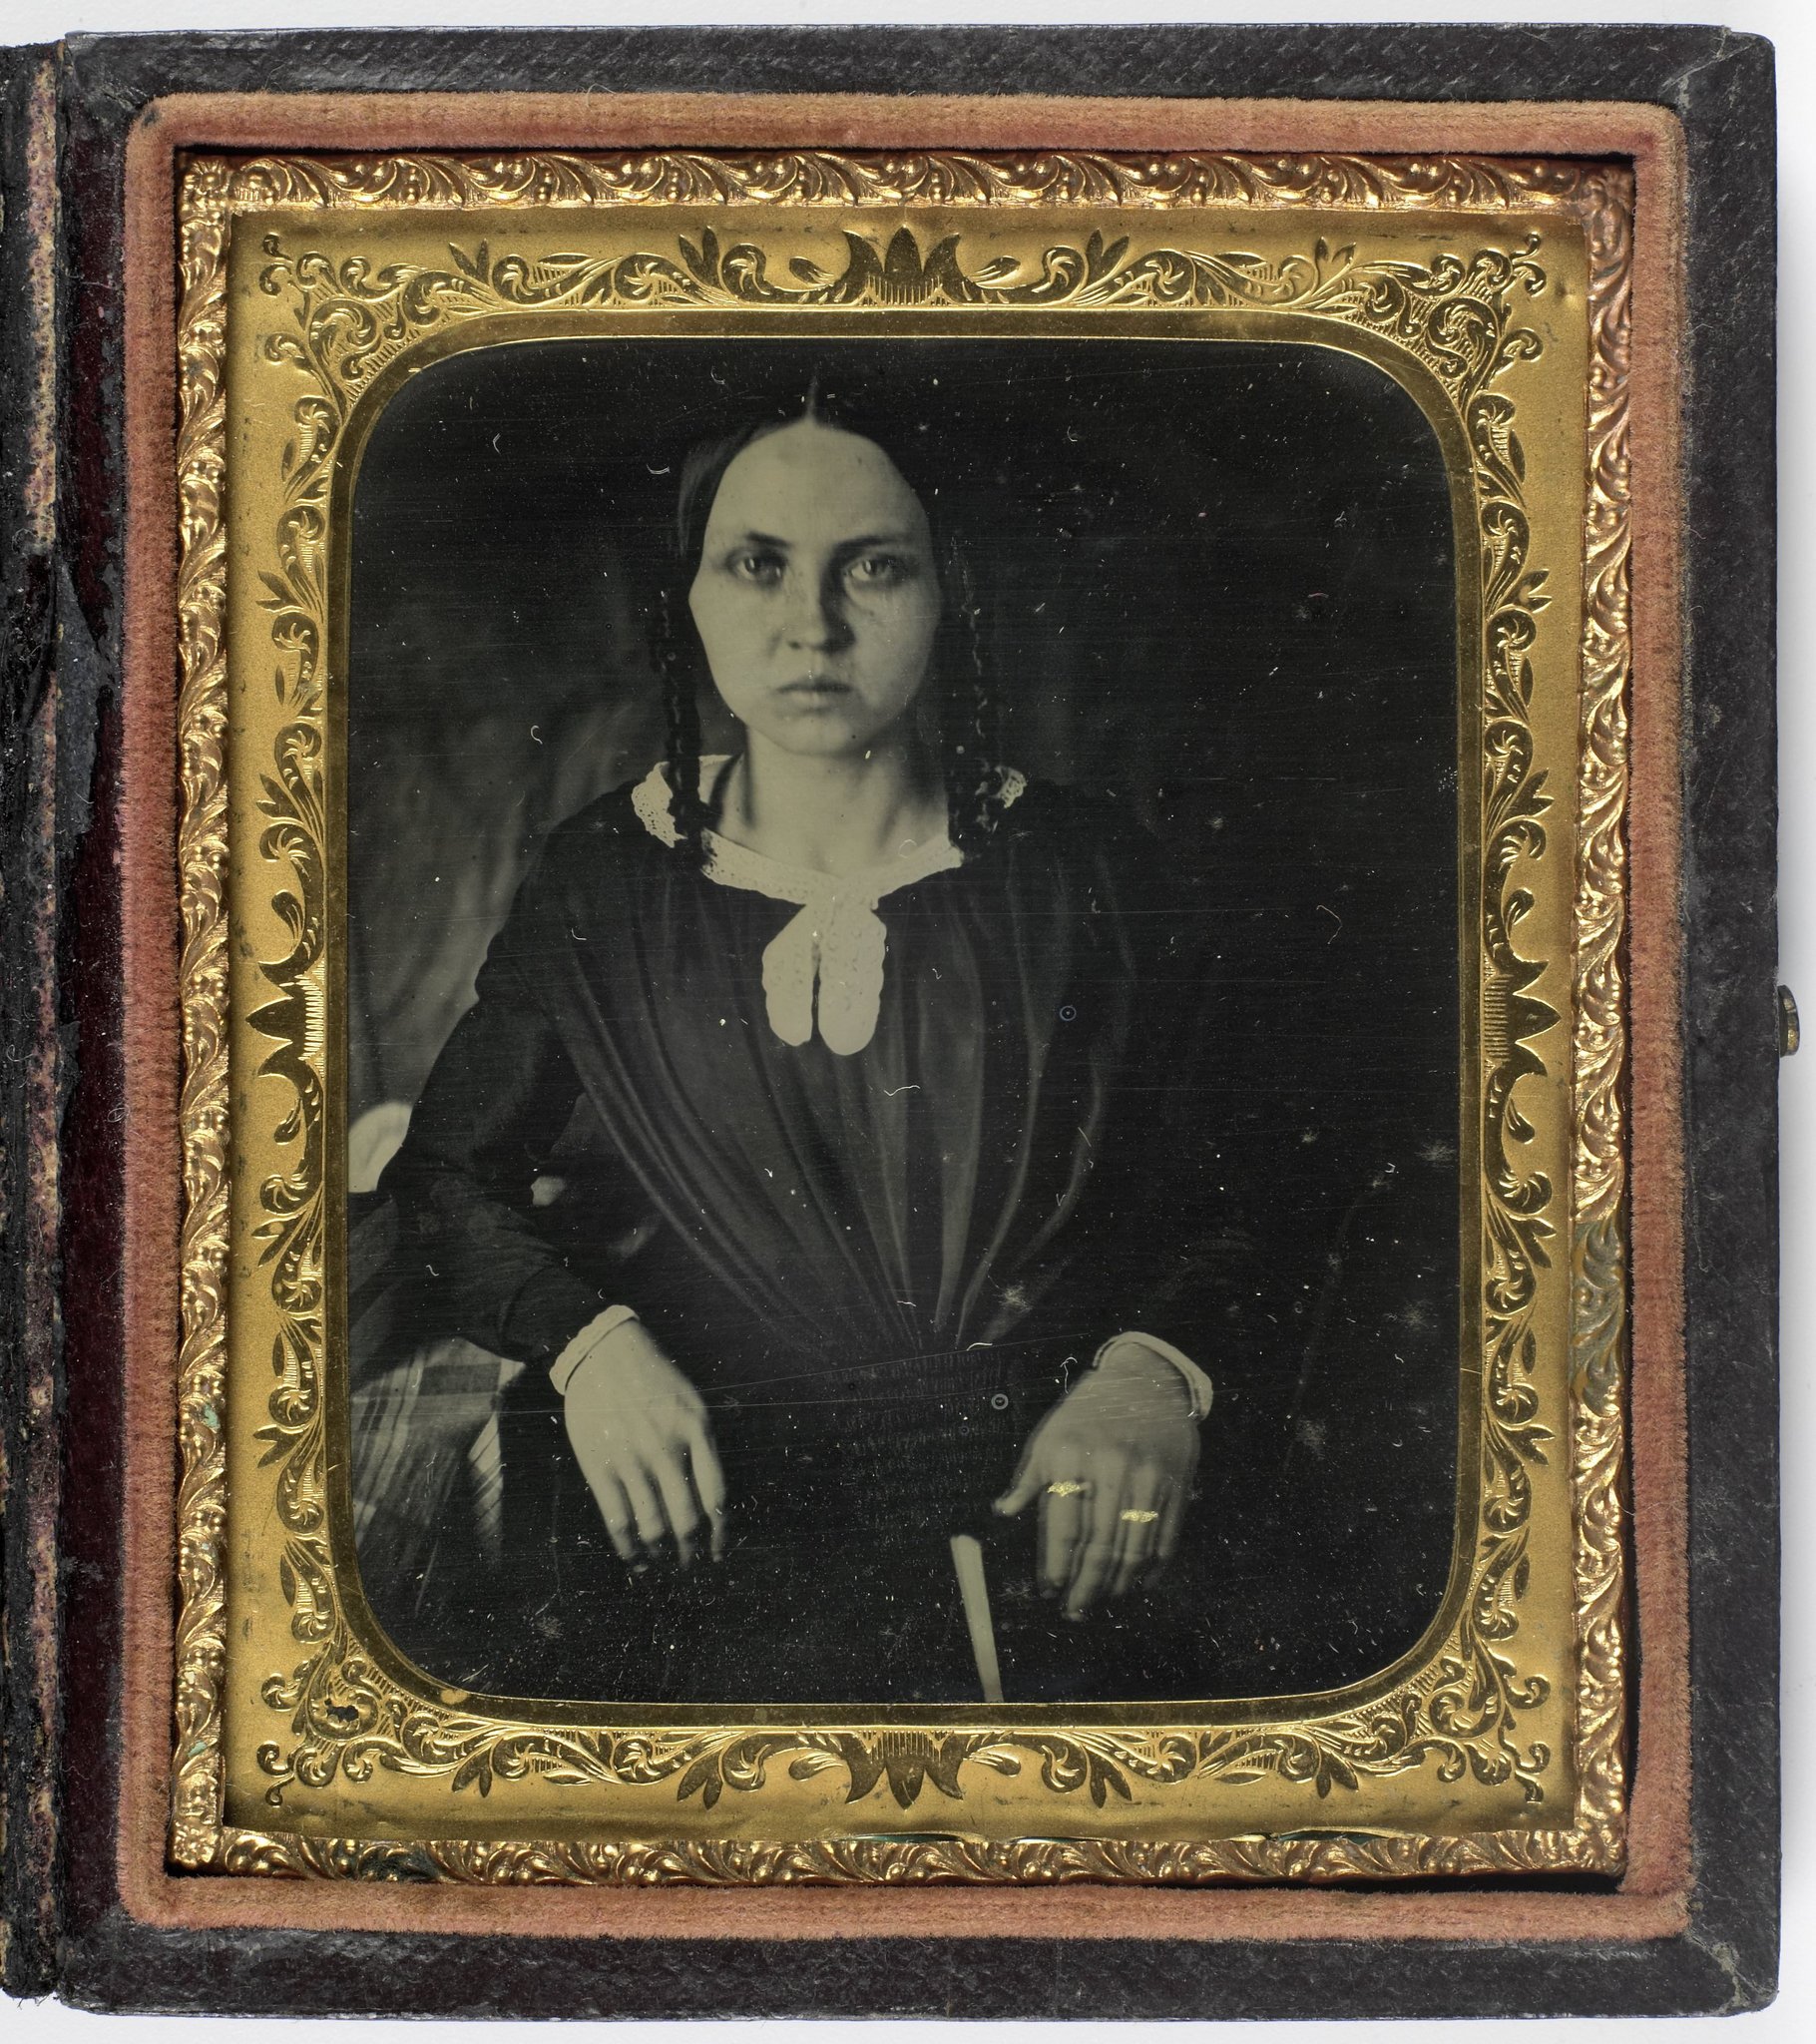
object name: photograph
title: Portret van een onbekende jonge vrouw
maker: Anonymous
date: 1852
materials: copper, glass, leather, velvet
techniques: daguerreotype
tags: adolescent, young woman, maiden, historical persons